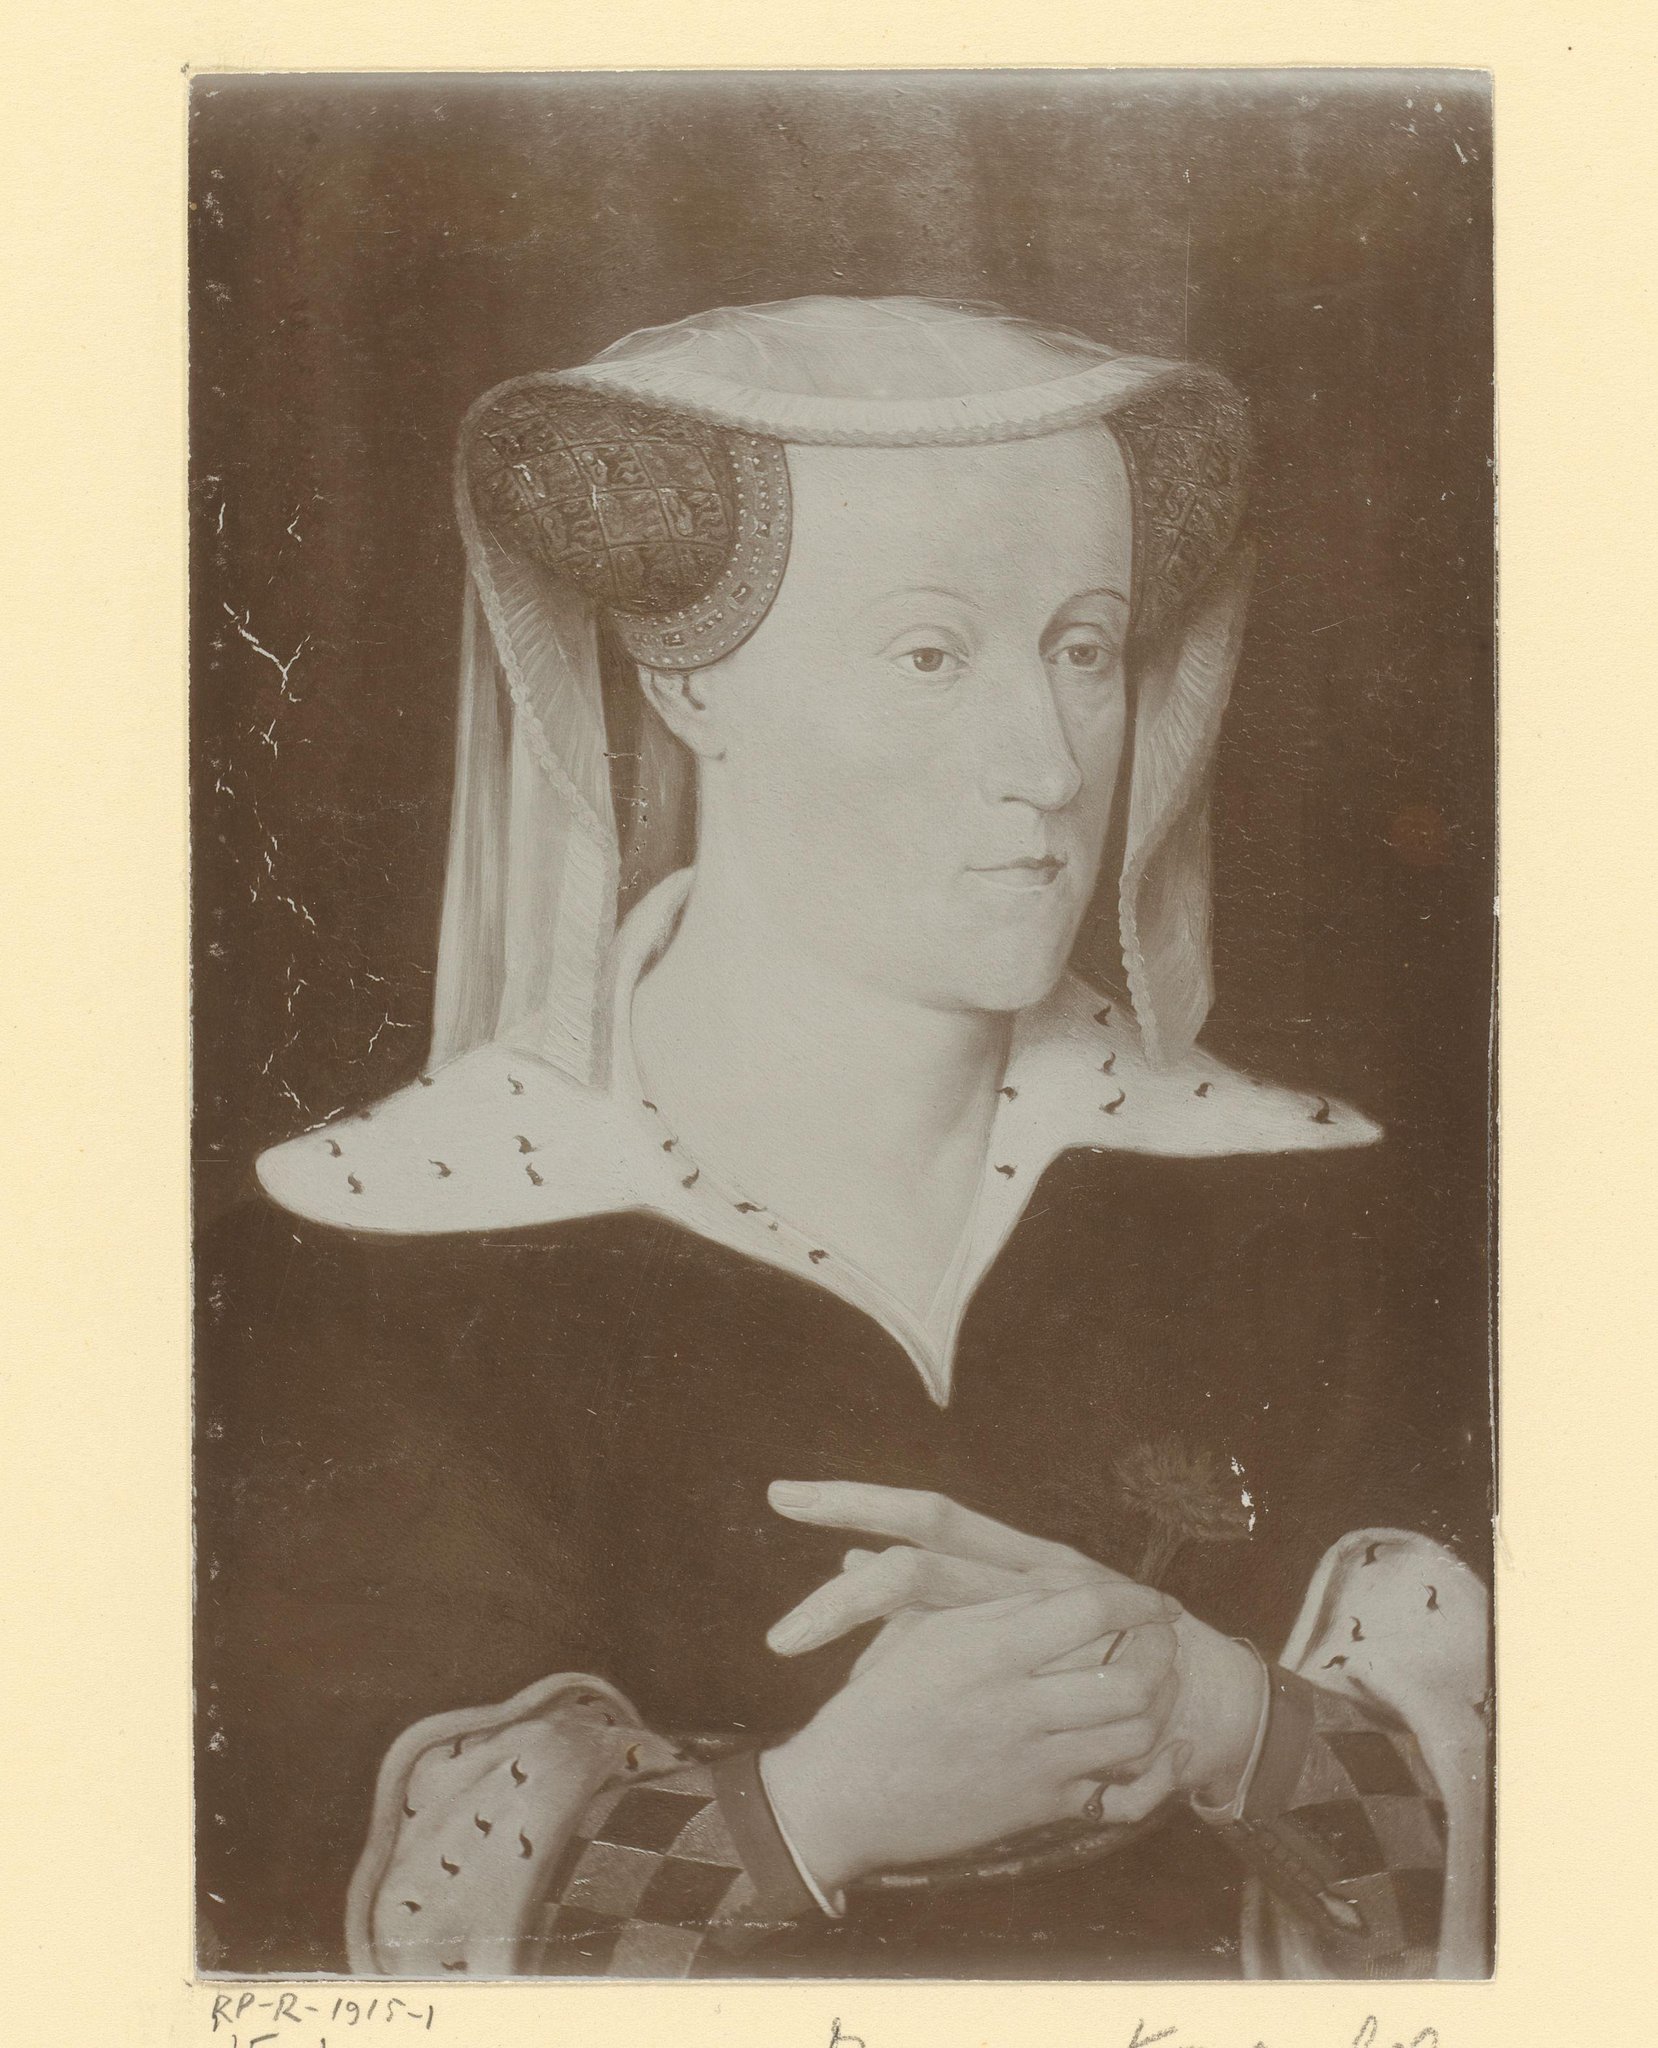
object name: photograph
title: Fotoreproductie van een geschilderd portret van Jacoba van Beieren, door Pieter Willem Sebes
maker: koop remmerts semplonius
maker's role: draughtsman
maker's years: 1847-1915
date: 1894-1915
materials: paper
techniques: collodion silver print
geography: amsterdam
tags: jacoba of bavaria (countess of hainaut), historical persons - bb - woman